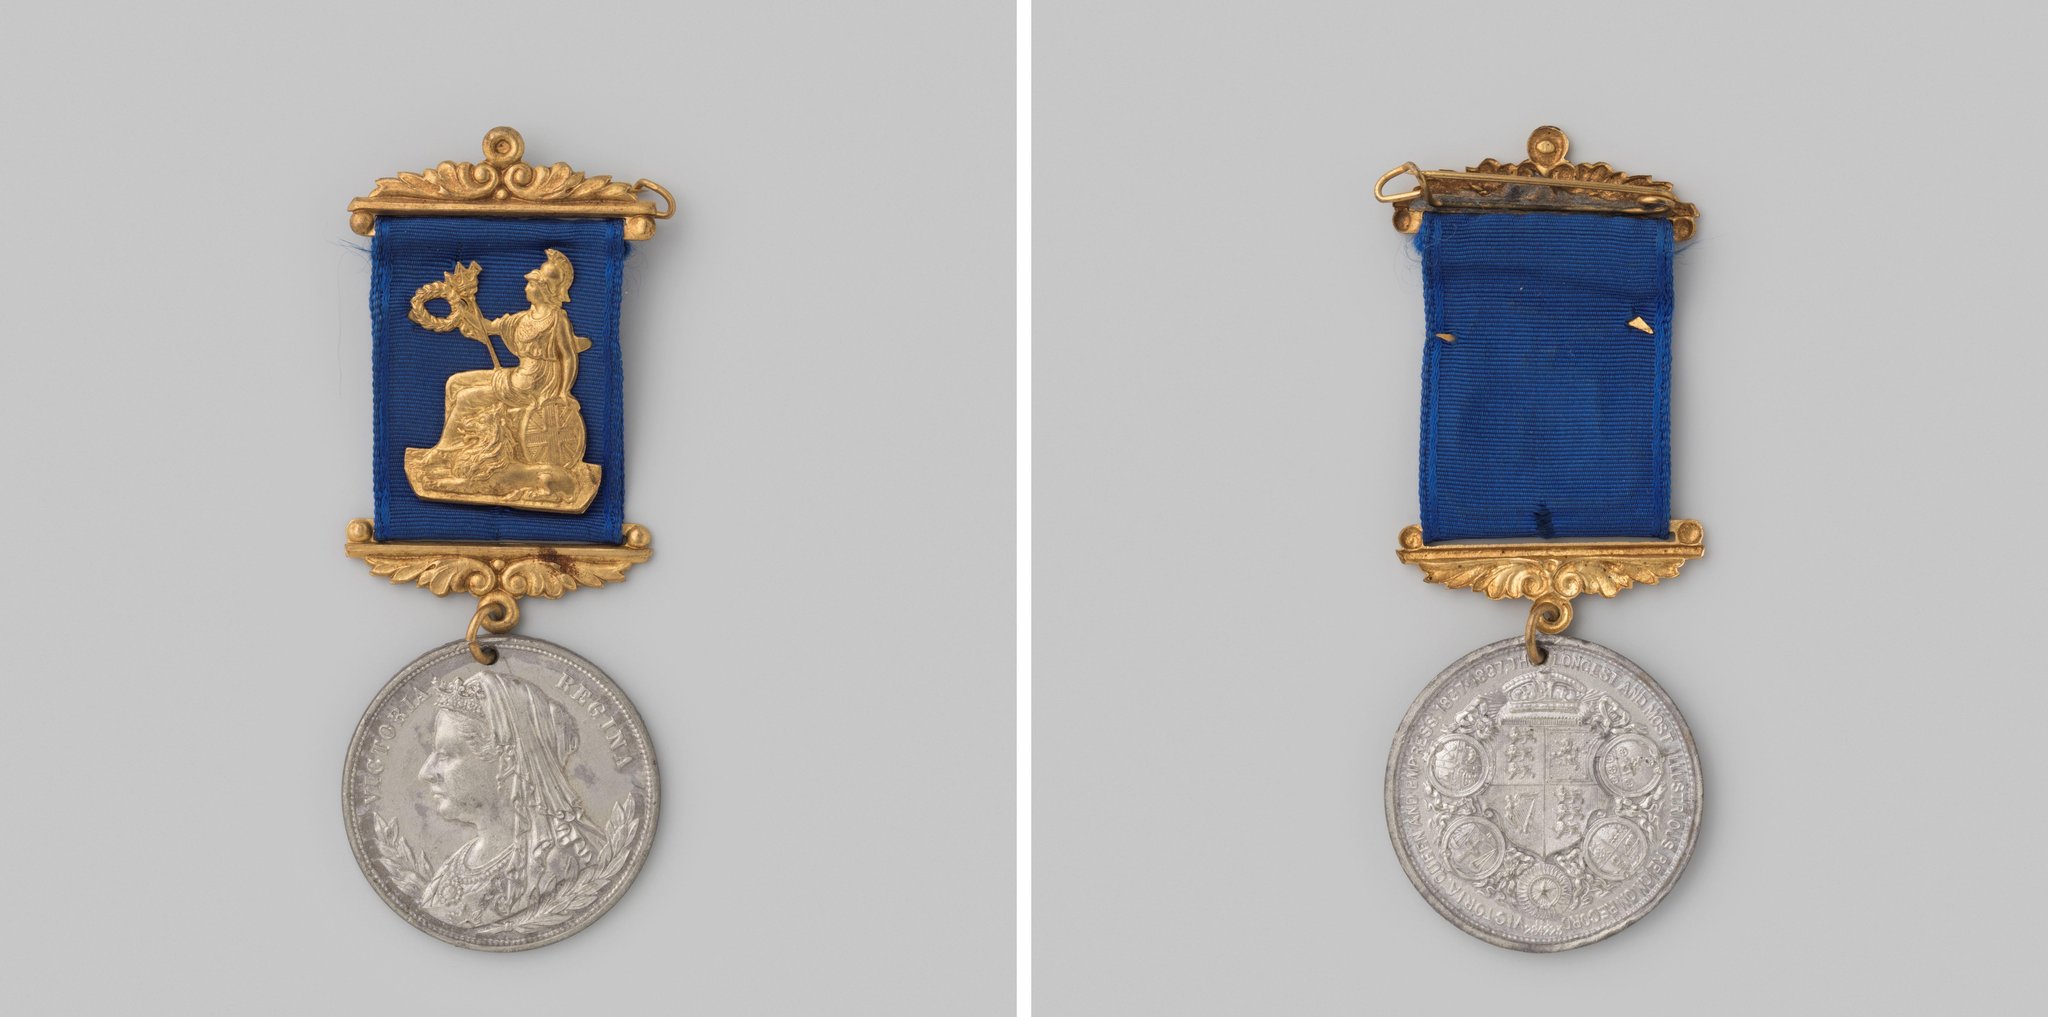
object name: history medal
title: Zestigjarig regeringsjubileum Koningin Victoria van Engeland 1897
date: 1897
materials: brass, textile, tin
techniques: striking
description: Tinnen penning met gat en draagring aan blauw lint met messing applique Brittannia en messing sierspeld, op de voorzijde het borstbeeld van Victoria naar links op lauwertakken, met omschrift, op de keerzijde het gekroonde Engelse wapenschild waarom vijf met linten verbonden medaillons, met omschrift.